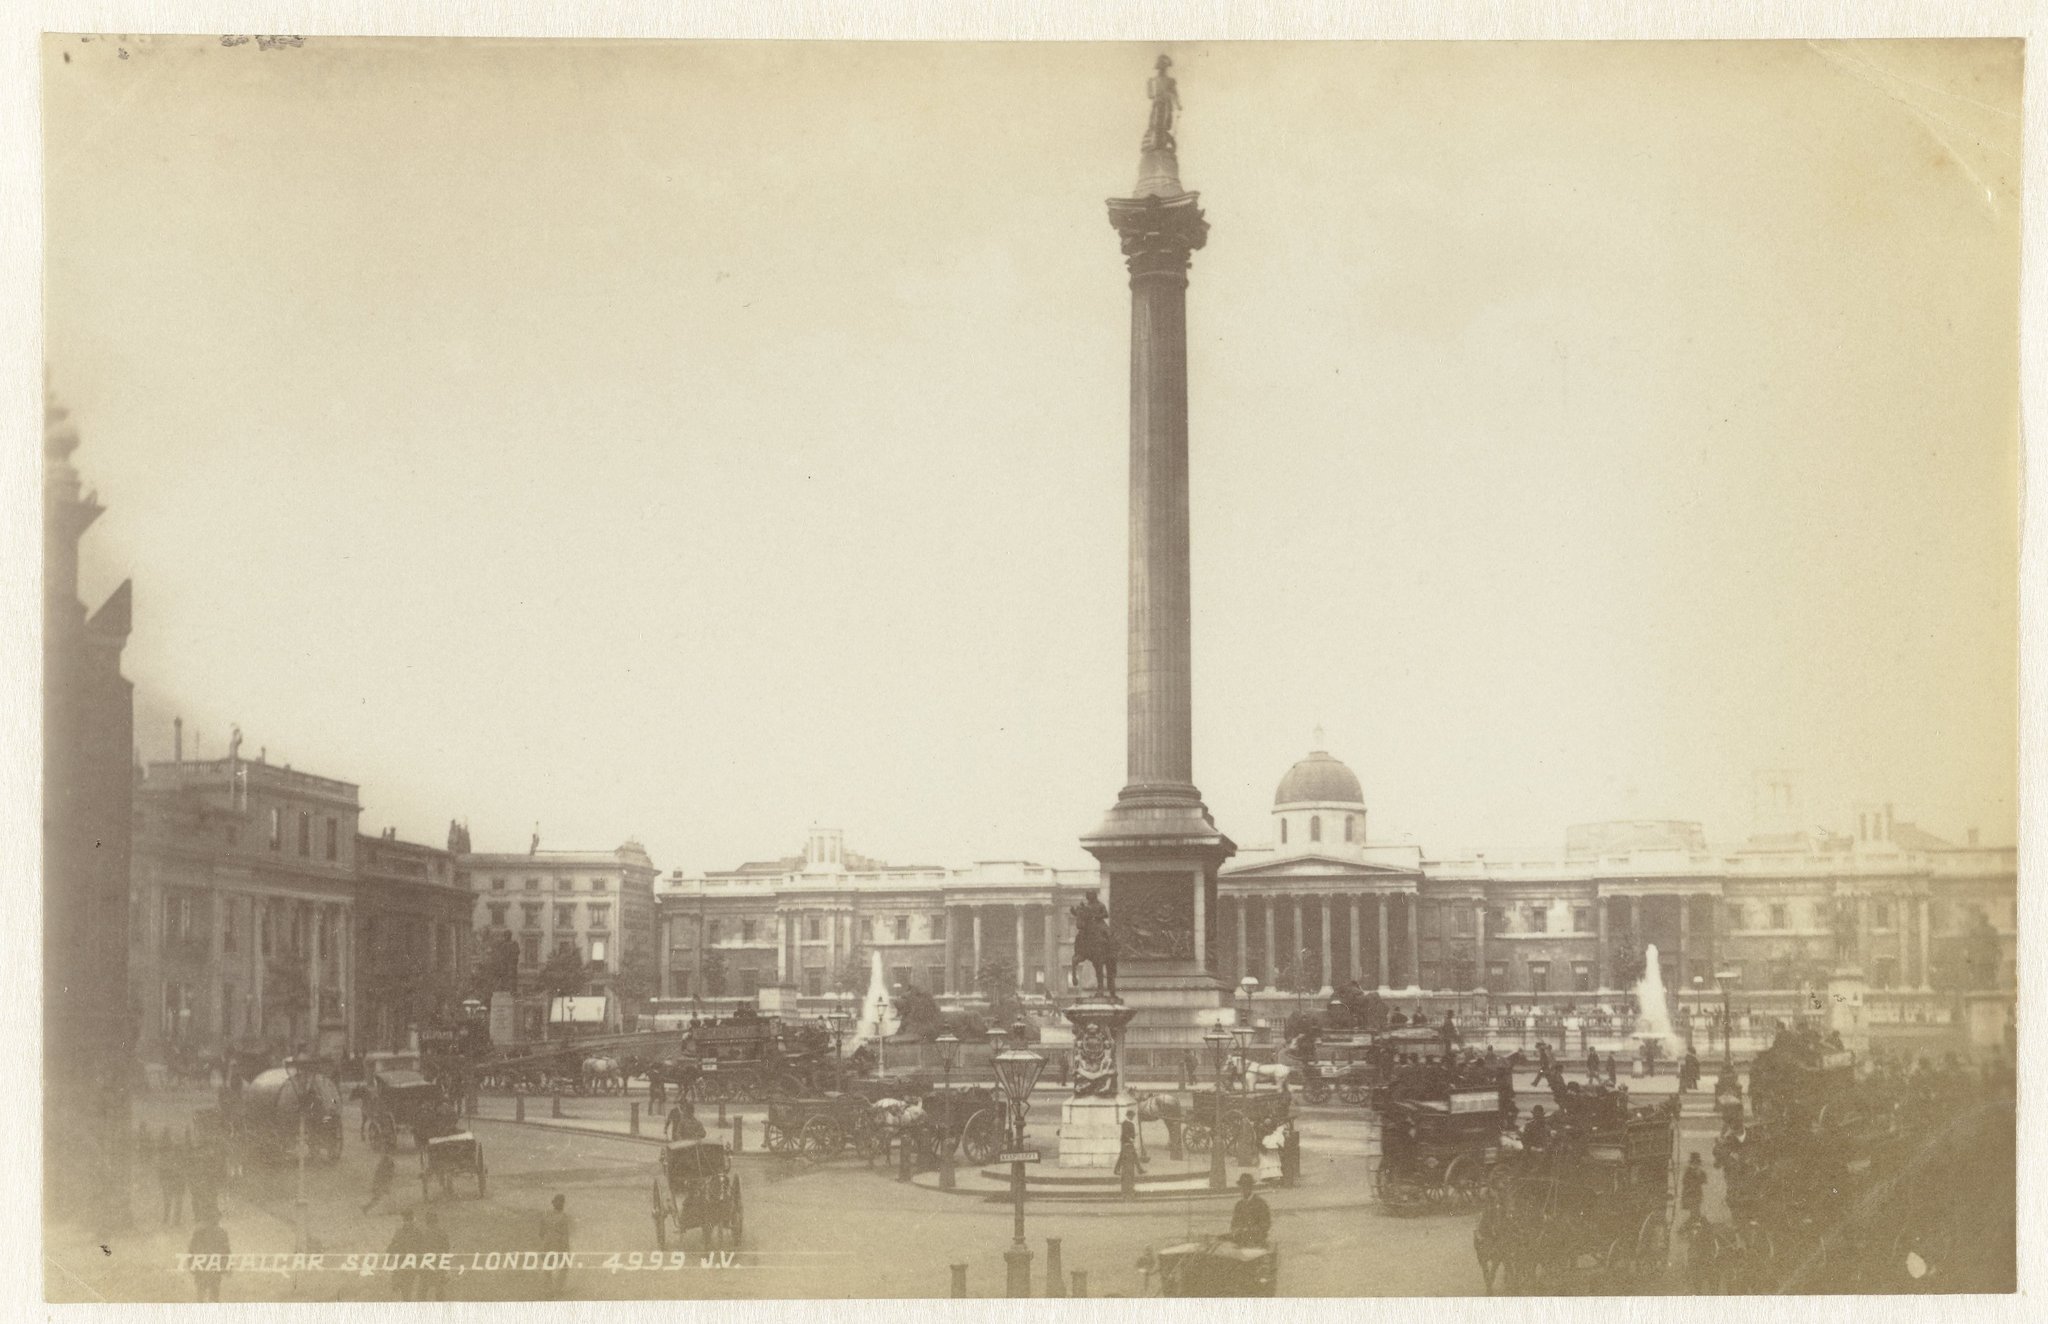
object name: photograph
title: Nelson's Column op Trafalgar Square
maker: james valentine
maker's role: fotograaf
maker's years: 1815-1880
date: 1851-1880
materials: paper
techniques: albumen print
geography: london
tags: square, place, circus, etc., monument, statue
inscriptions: number: ‘4999’